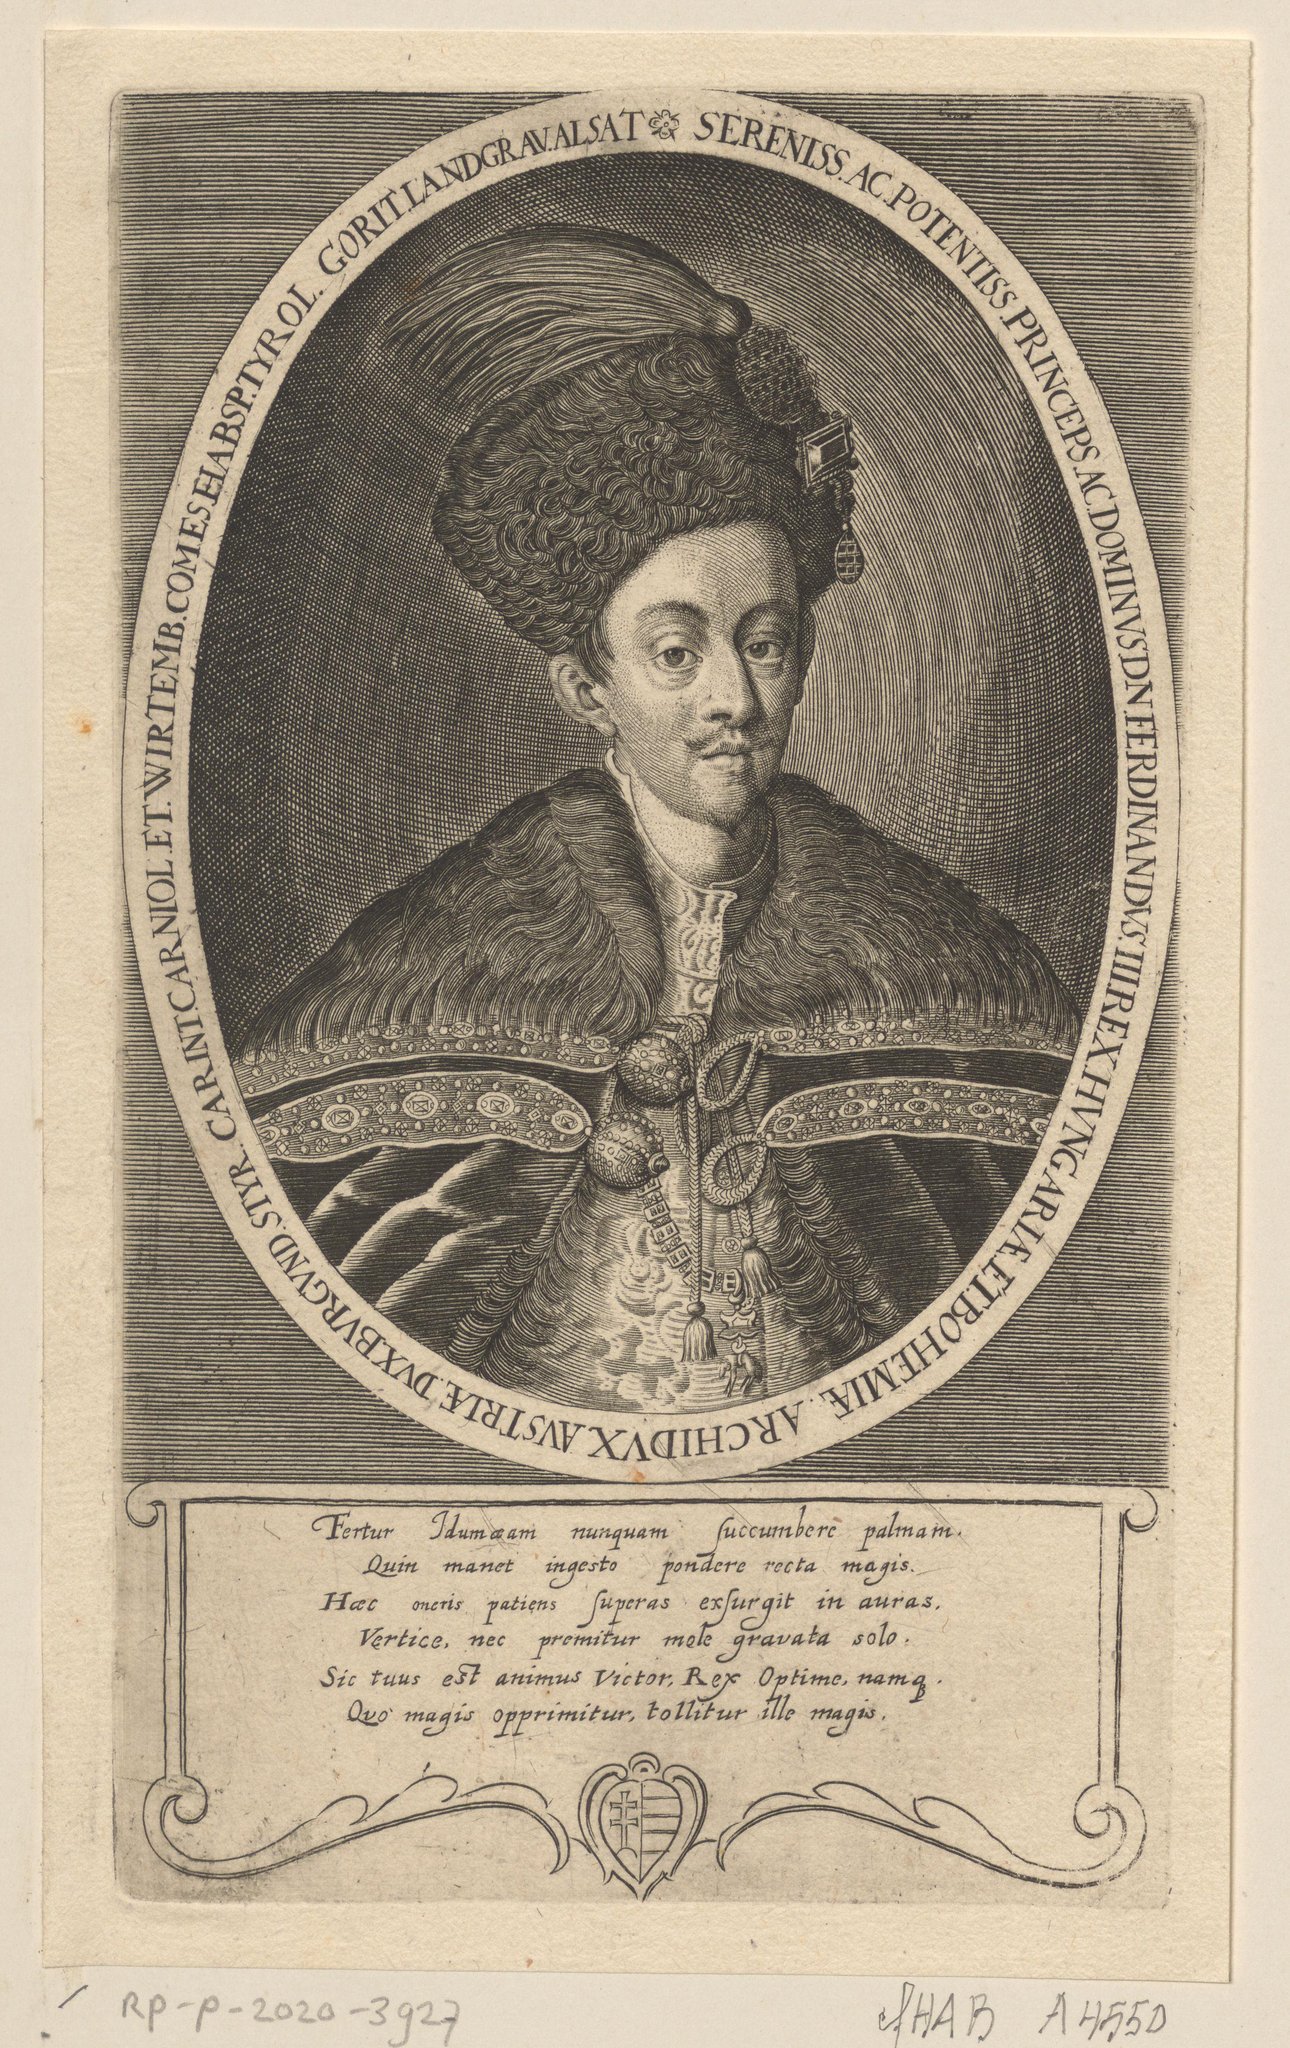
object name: print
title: Portret van keizer Ferdinand III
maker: Anonymous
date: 1627-1637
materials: paper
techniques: engraving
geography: germany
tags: vienna, ferdinand iii (duits keizer), historical persons, knighthood order of the golden fleece, emperor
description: Met zesregelig vers in het Latijn onder het portret.